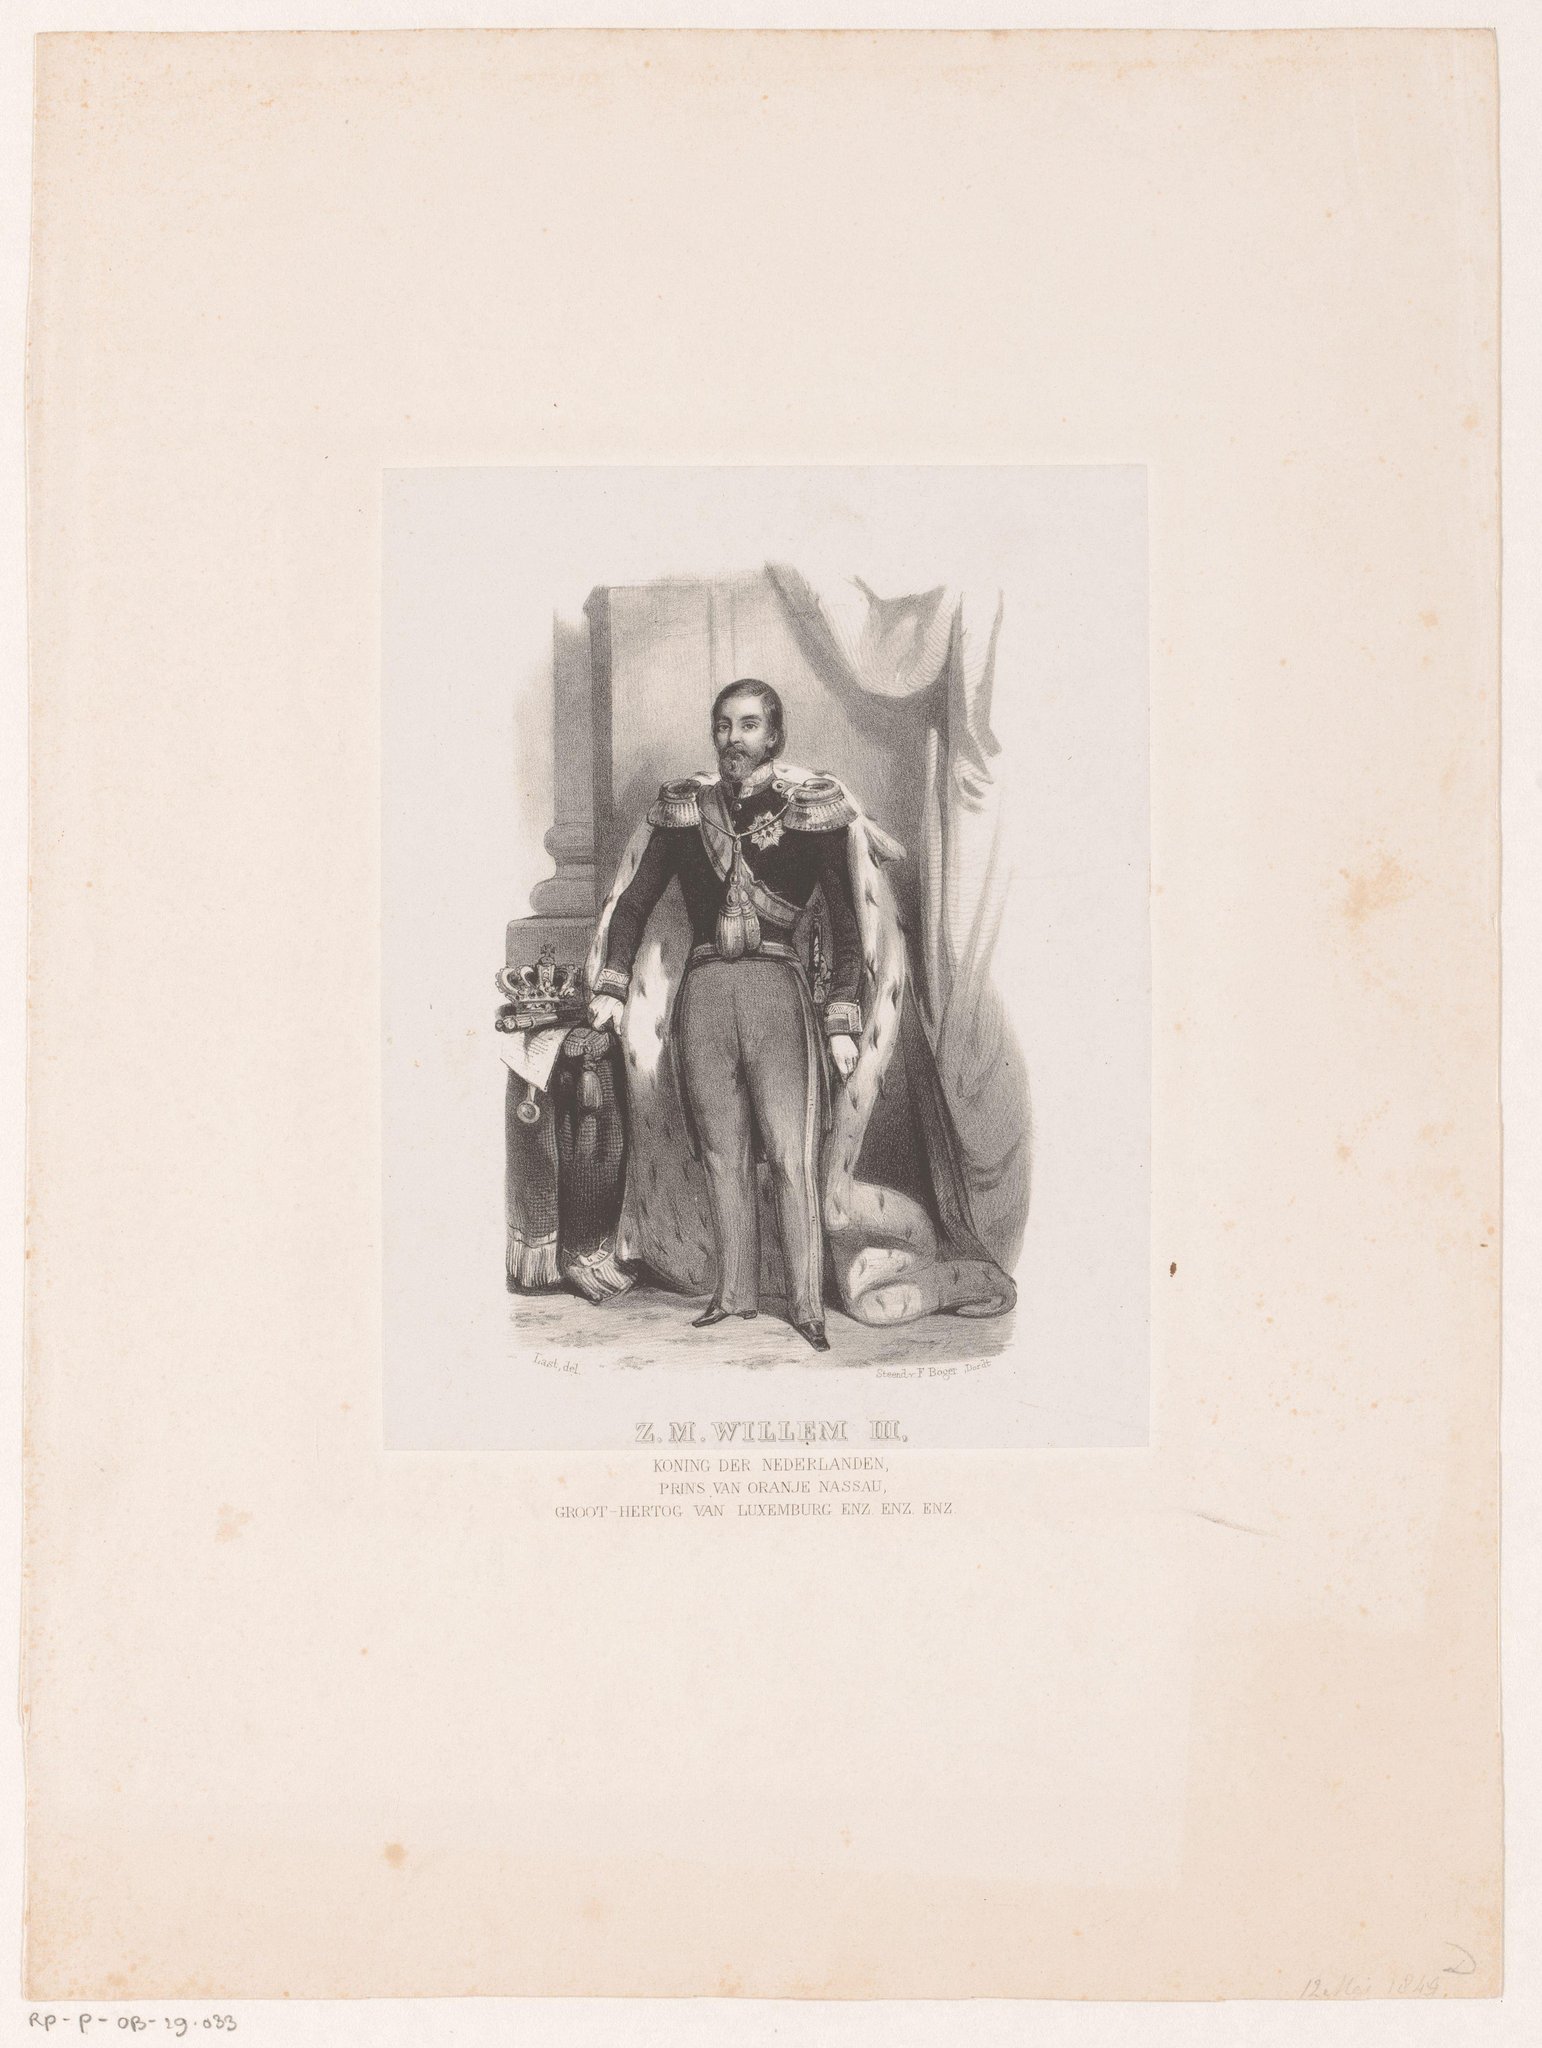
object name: print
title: Portret van Willem III, koning der Nederlanden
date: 1846-1876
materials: paper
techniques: lithograph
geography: dordrecht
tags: brussels, willem iii (koning der nederlanden), imperial mantle (symbol of sovereignty), insignia and symbols of sovereignty (crown, diadem, sceptre, orb, seal, standard, cloak, pectoral), royal mantle (symbol of sovereignty)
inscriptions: collector's mark: Lugt 2228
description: De koning draagt de hermelijnen mantel en staat naast een tafel met regalia.